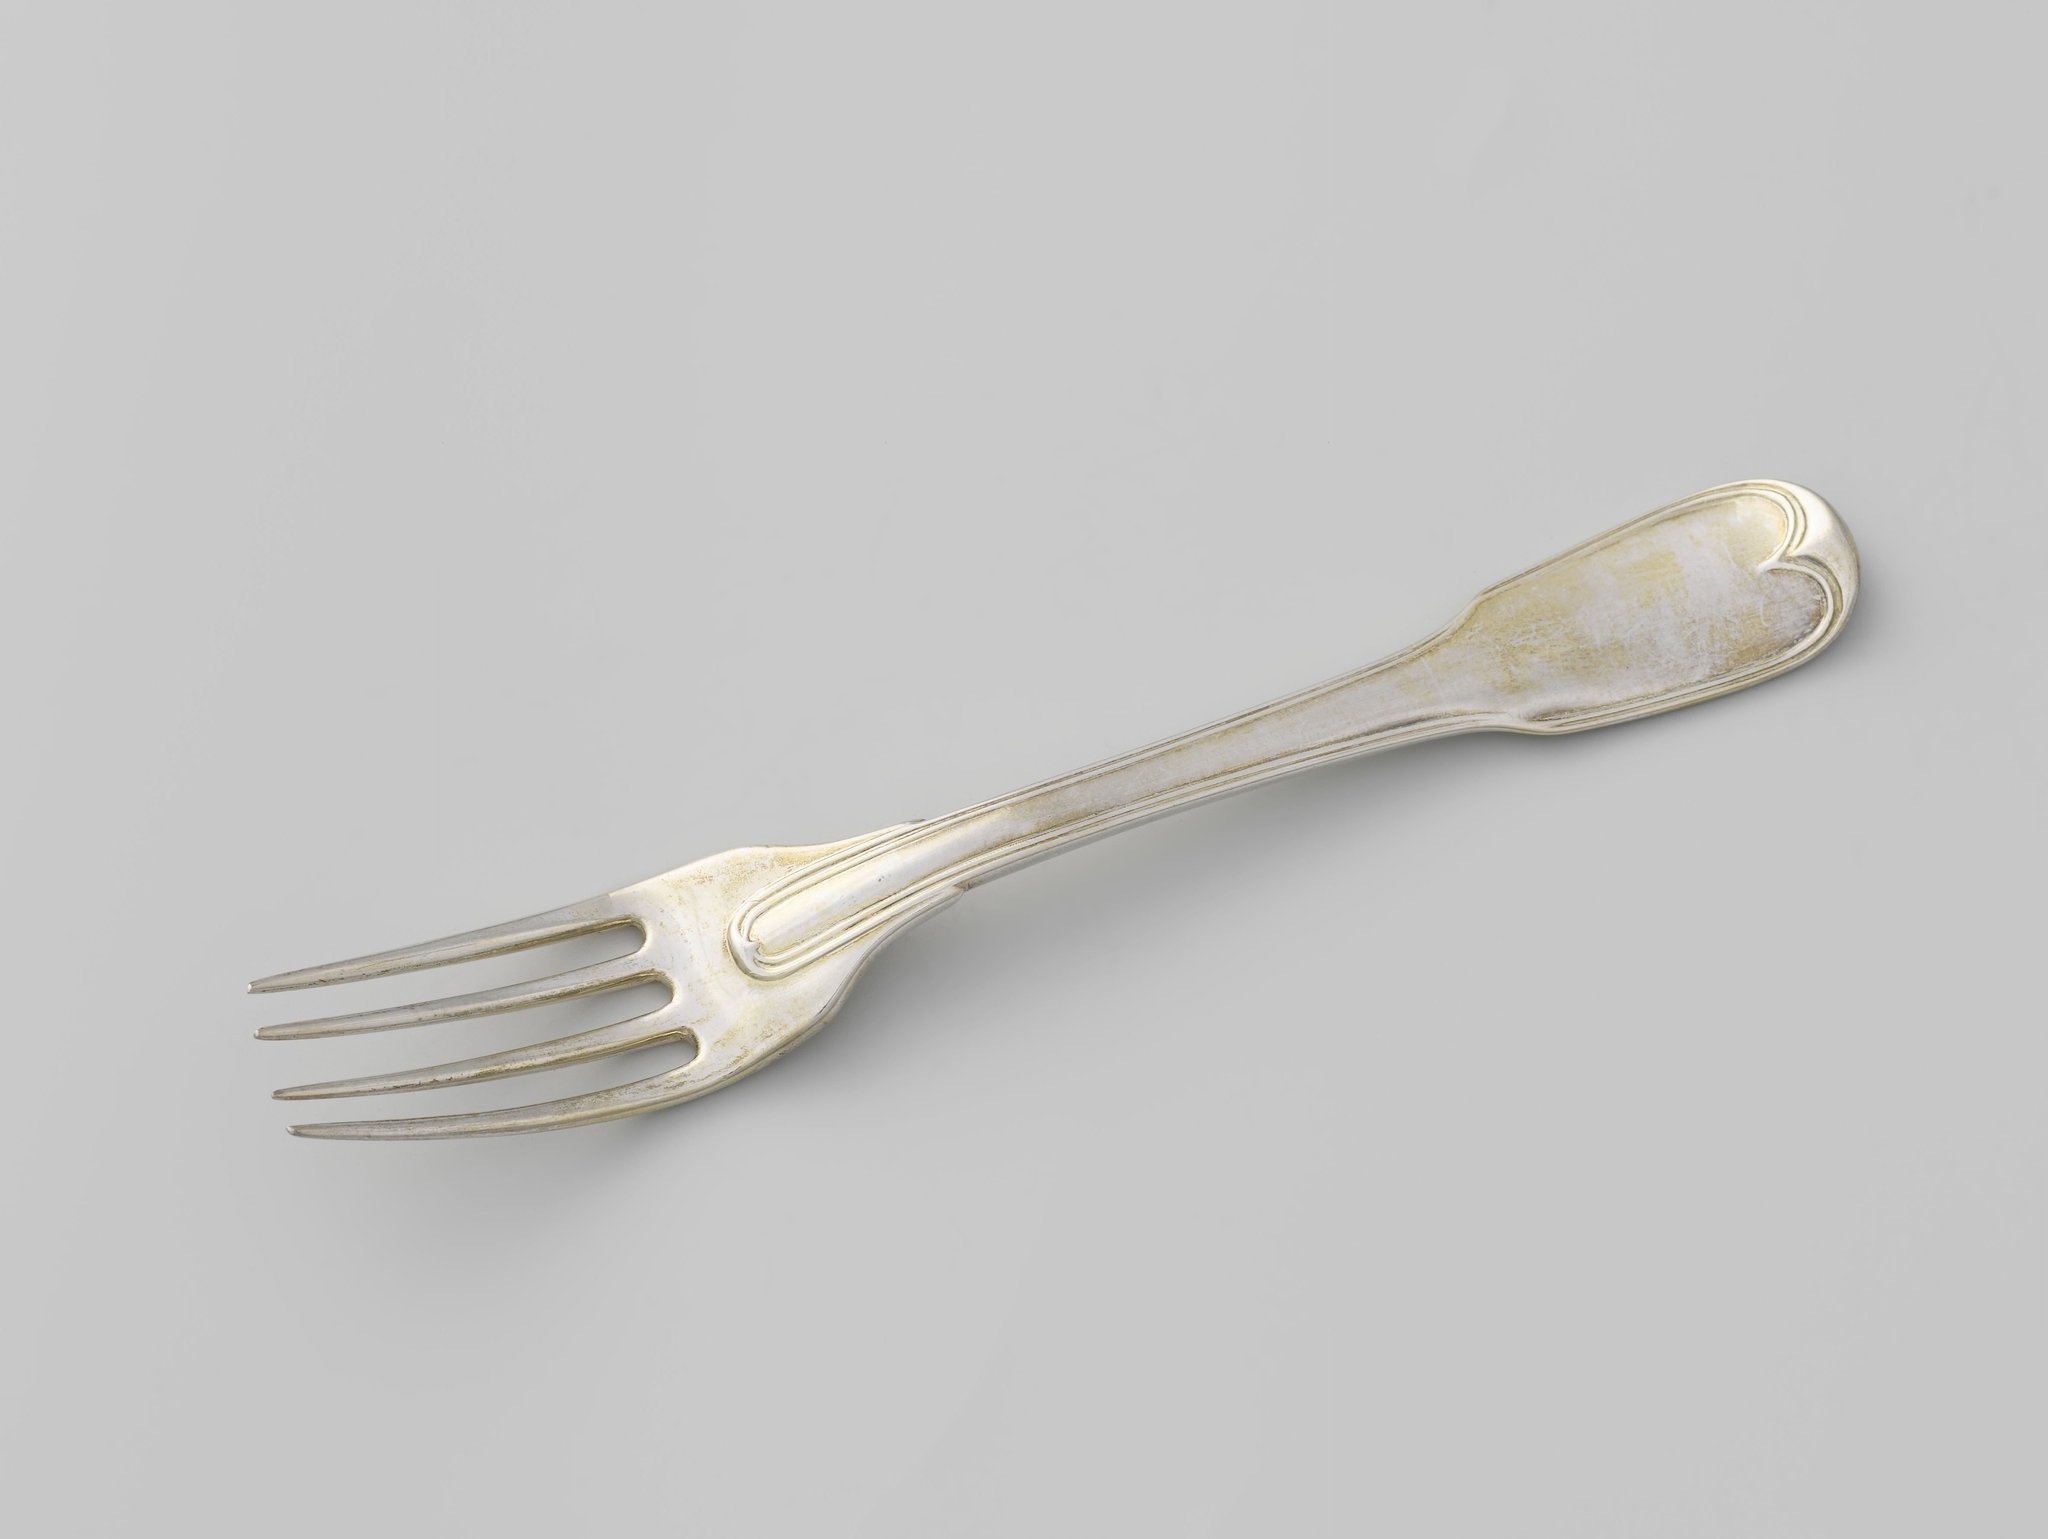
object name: fork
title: Vork met het helmteken Clifford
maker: roelof helweg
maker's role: silversmith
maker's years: 1758-1843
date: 1806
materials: silver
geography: amsterdam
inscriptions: maker's mark: ‘RH in ovaal’, date letter: ‘X (=1806)’, alloy mark: ‘Hollandse leeuw’, town mark: ‘Amsterdam’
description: De viertandige vork is aan zowel boven- als onderzijde door middel van enkel lof verbonden met de platte, gebogen steel, die zich verbreedt naar het spatelvormige uiteinde. Boven- en onderzijde van de steel worden omgeven door een dubbele filetrand, die bij het uiteinde ingezwenkt is. Op de onderzijde van de spatel is het helmteken Clifford gegraveerd.